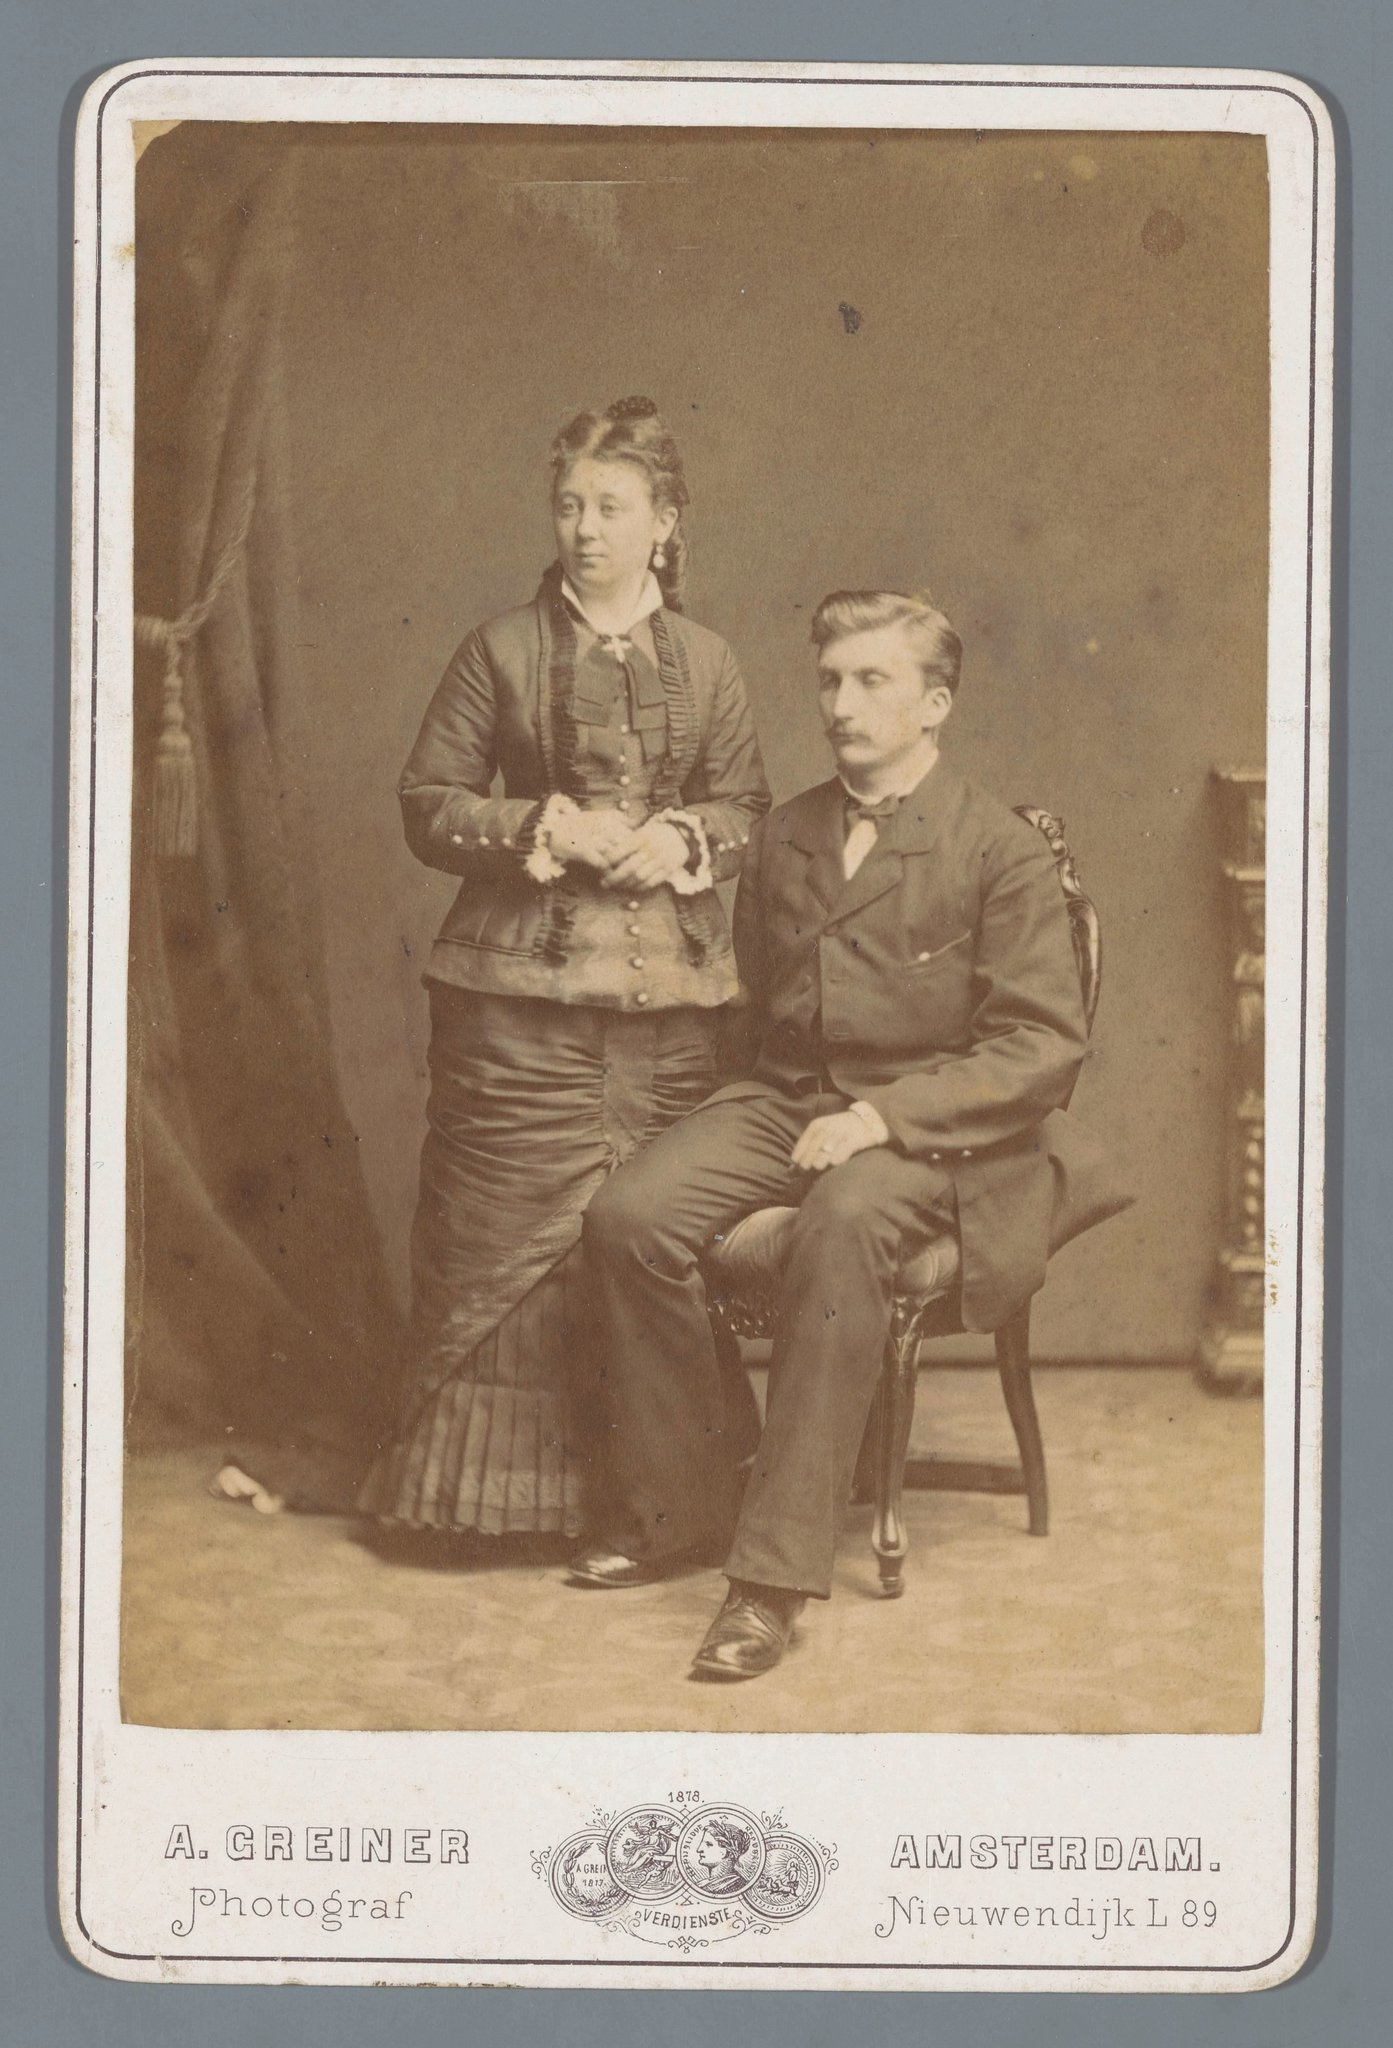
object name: cabinet photograph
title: Portret van een onbekende man en vrouw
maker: albert greiner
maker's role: fotograaf, fotostudio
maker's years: 1833-1890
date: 1861-1890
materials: cardboard, photographic support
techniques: albumen print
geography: amsterdam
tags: adult woman, studio requisites ~ photographer, adult man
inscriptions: name: ‘A. Greiner Photograf Amsterdam Nieuwendijk L 89’